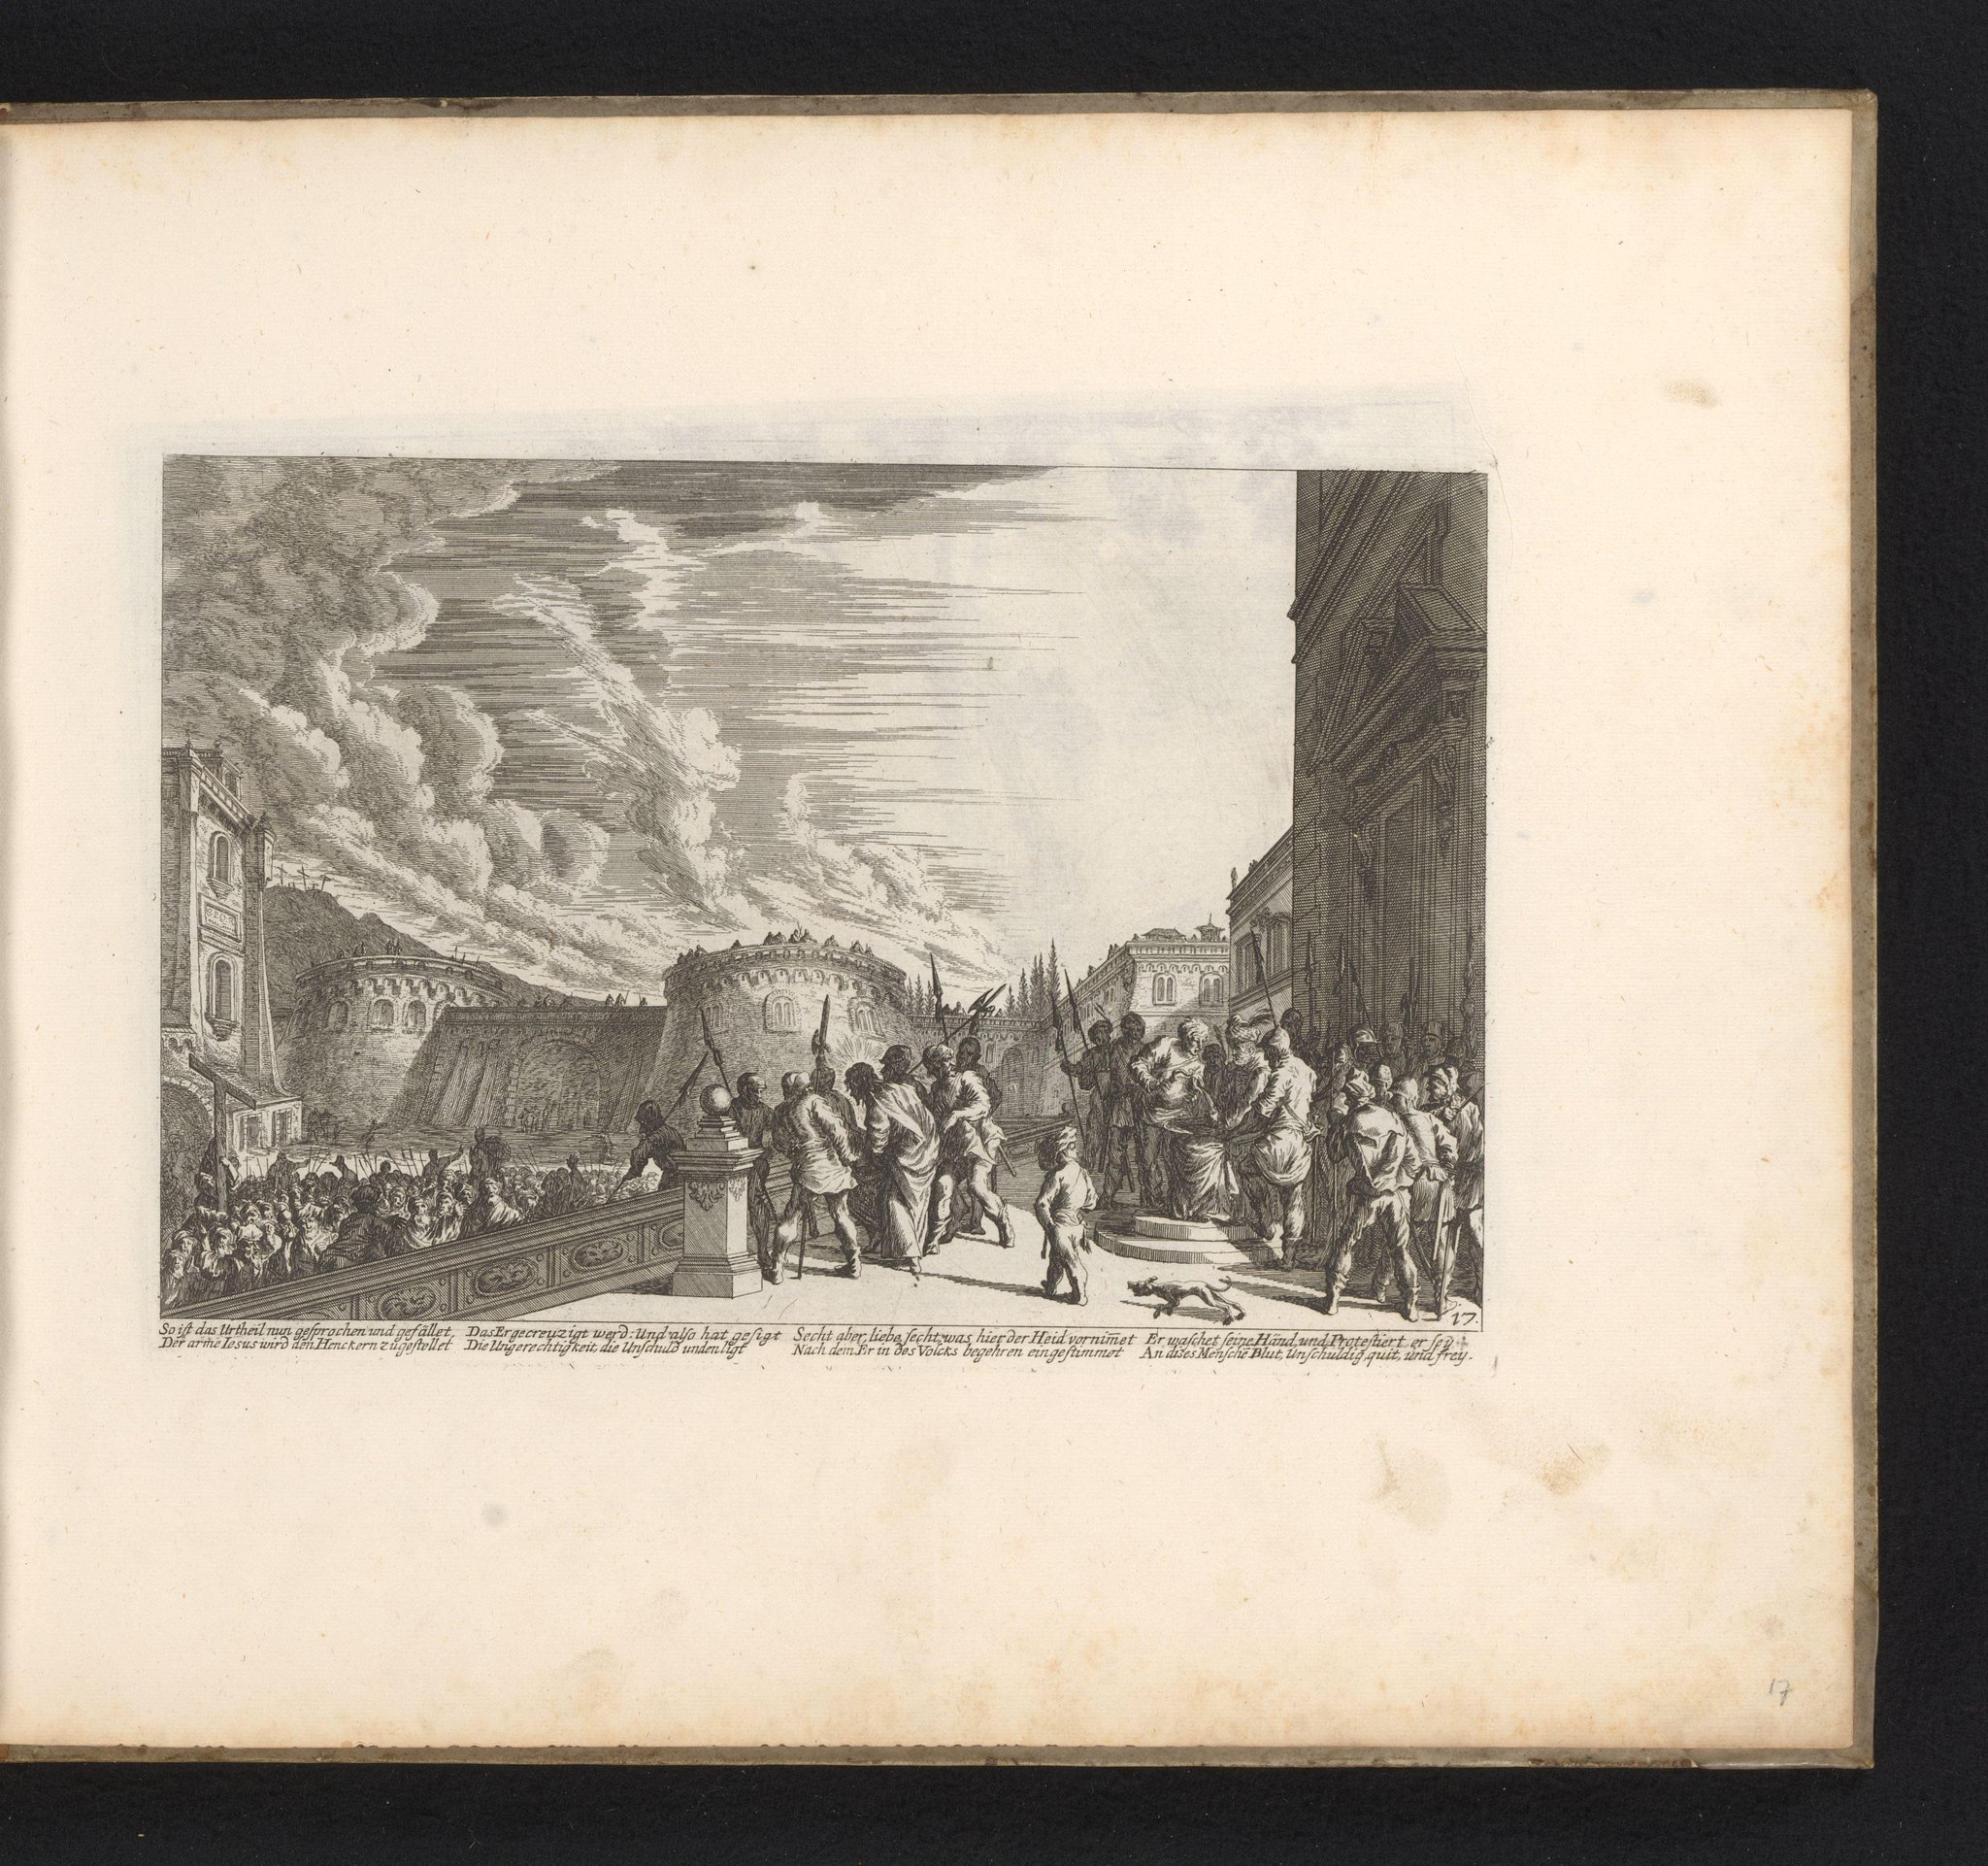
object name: print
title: Pilatus wast zijn handen in onschuld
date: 1670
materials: paper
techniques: etching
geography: augsburg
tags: pilate washing his hands (in innocence)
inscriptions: collector's mark: Lugt 2228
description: Tekst in het Duits in de ondermarge. Rechtsonder genummerd: 17. Prent maakt deel uit van een album.